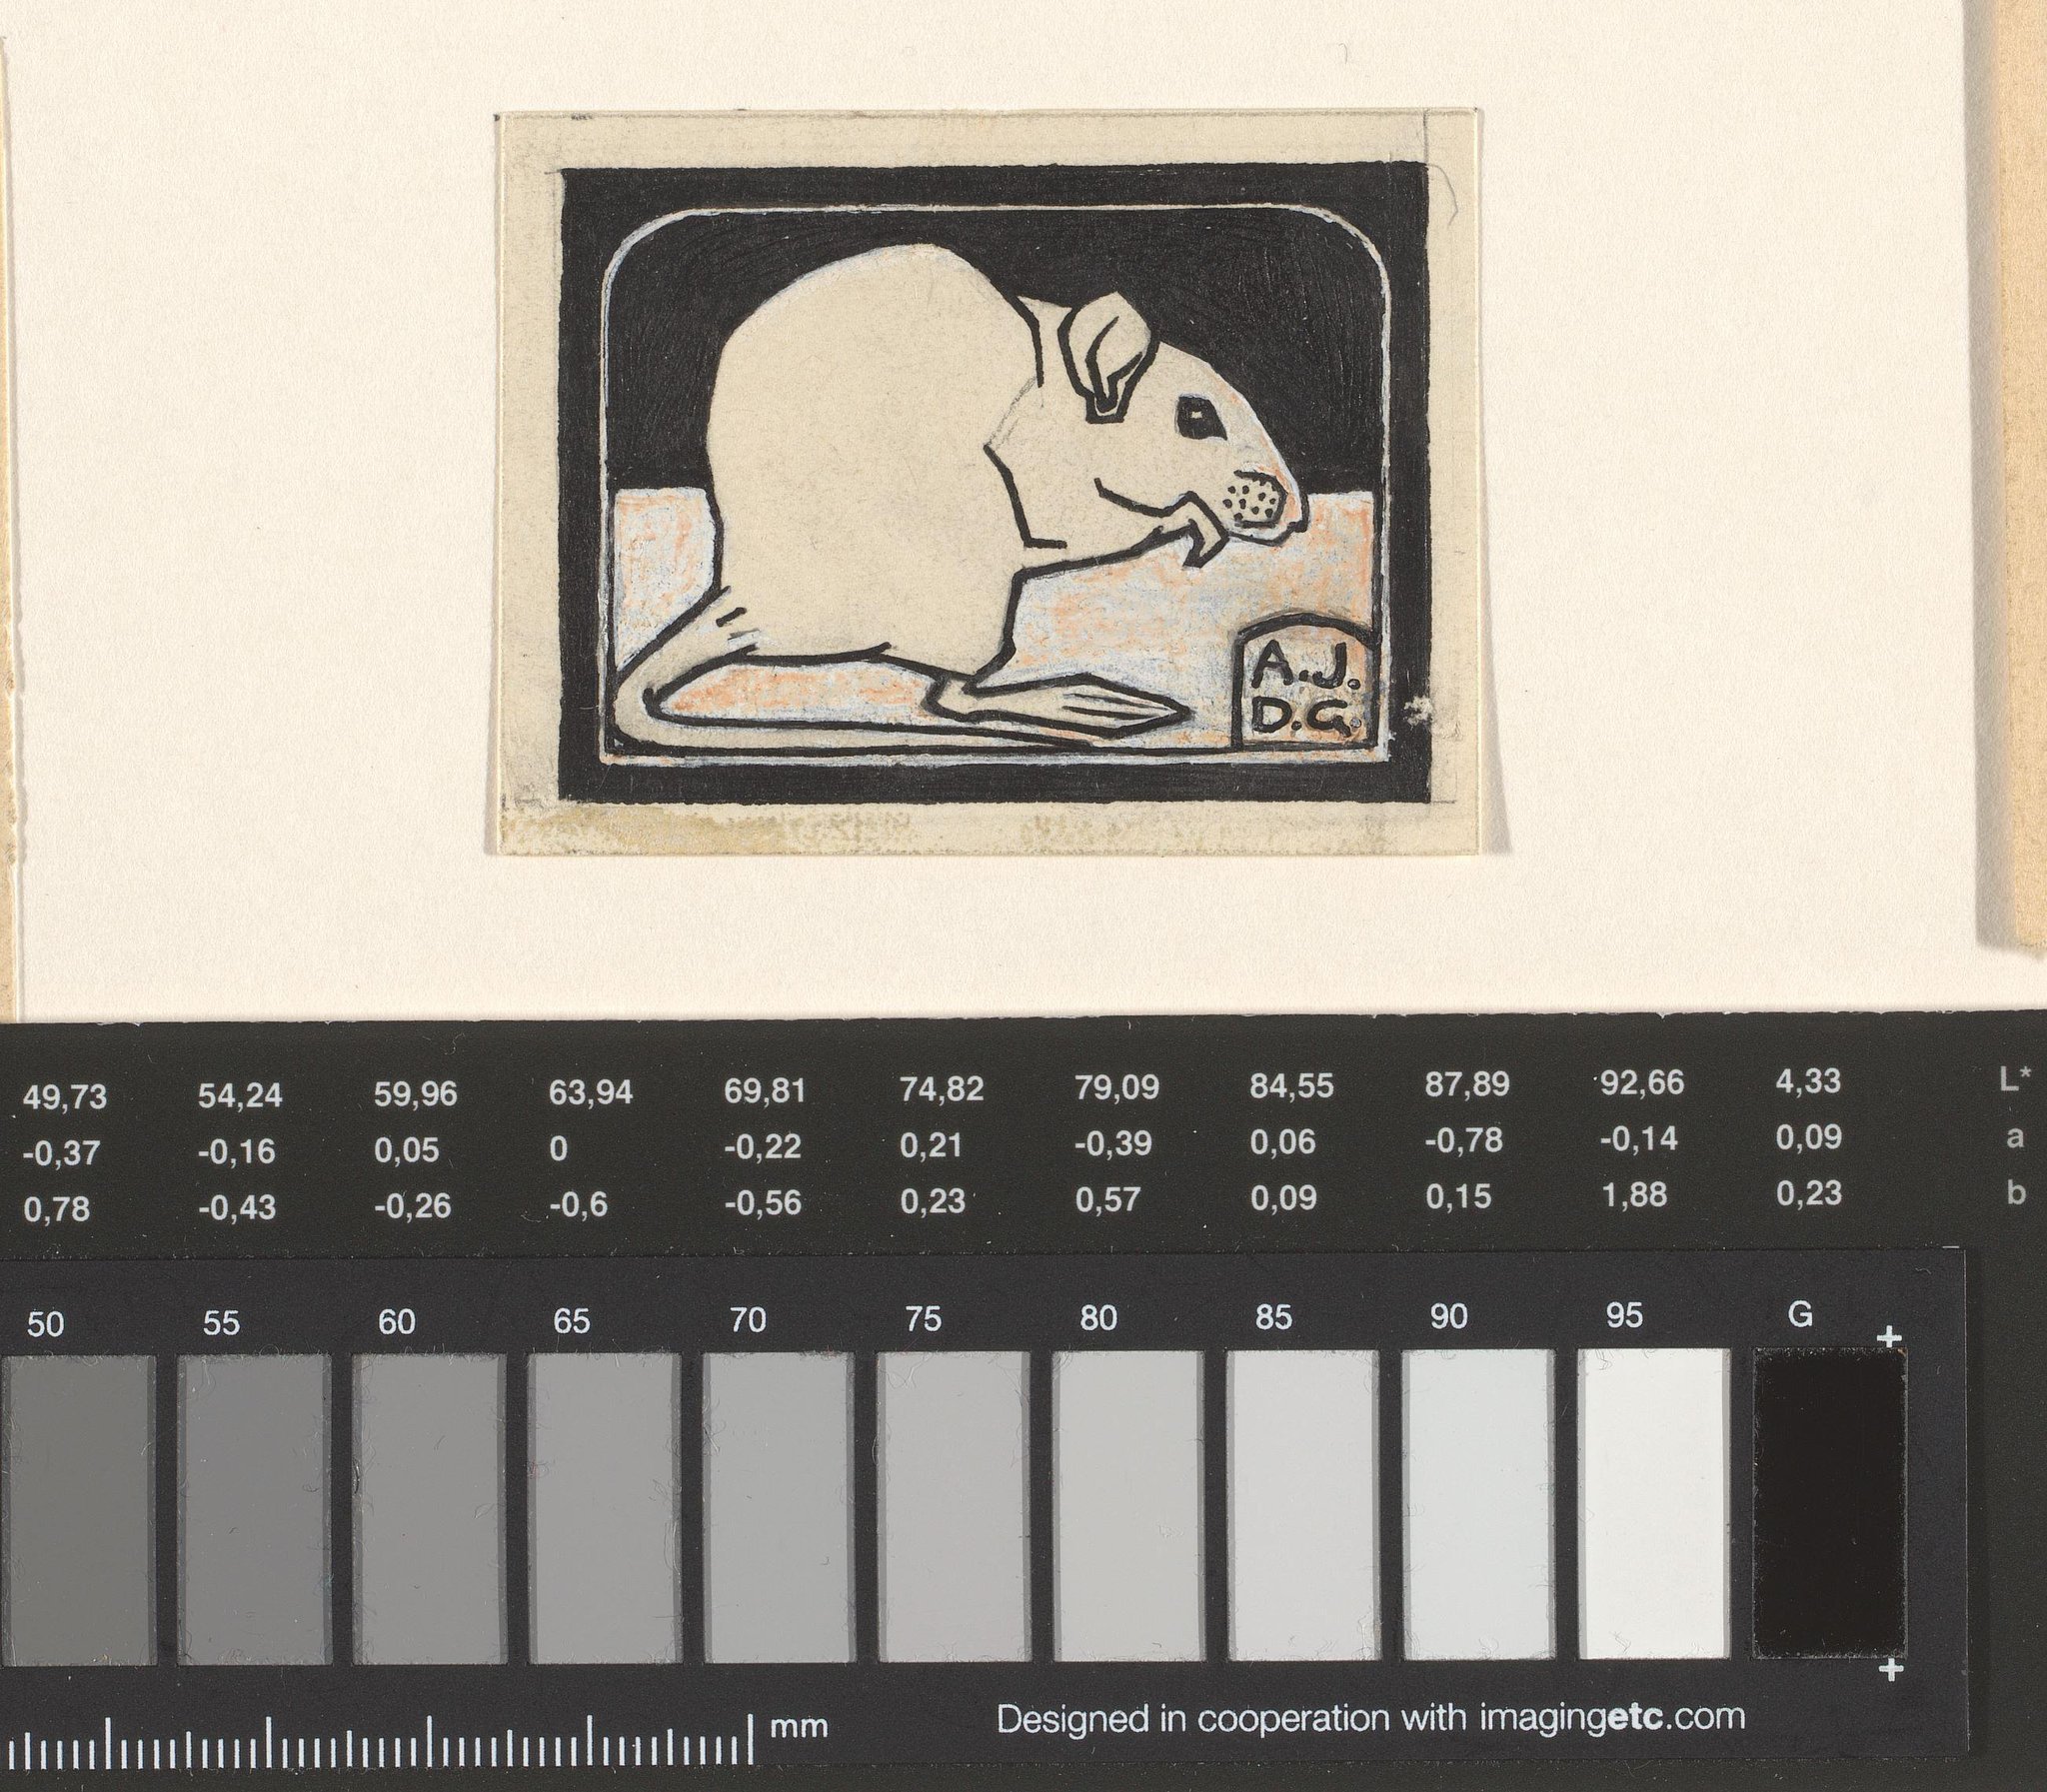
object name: drawing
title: Muis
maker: julie de graag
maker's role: draughtsman, print maker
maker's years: 1877-1924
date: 1887-1924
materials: paint, ink, paper, pencil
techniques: brush, pen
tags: rodents: mouse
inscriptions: number: ‘45’